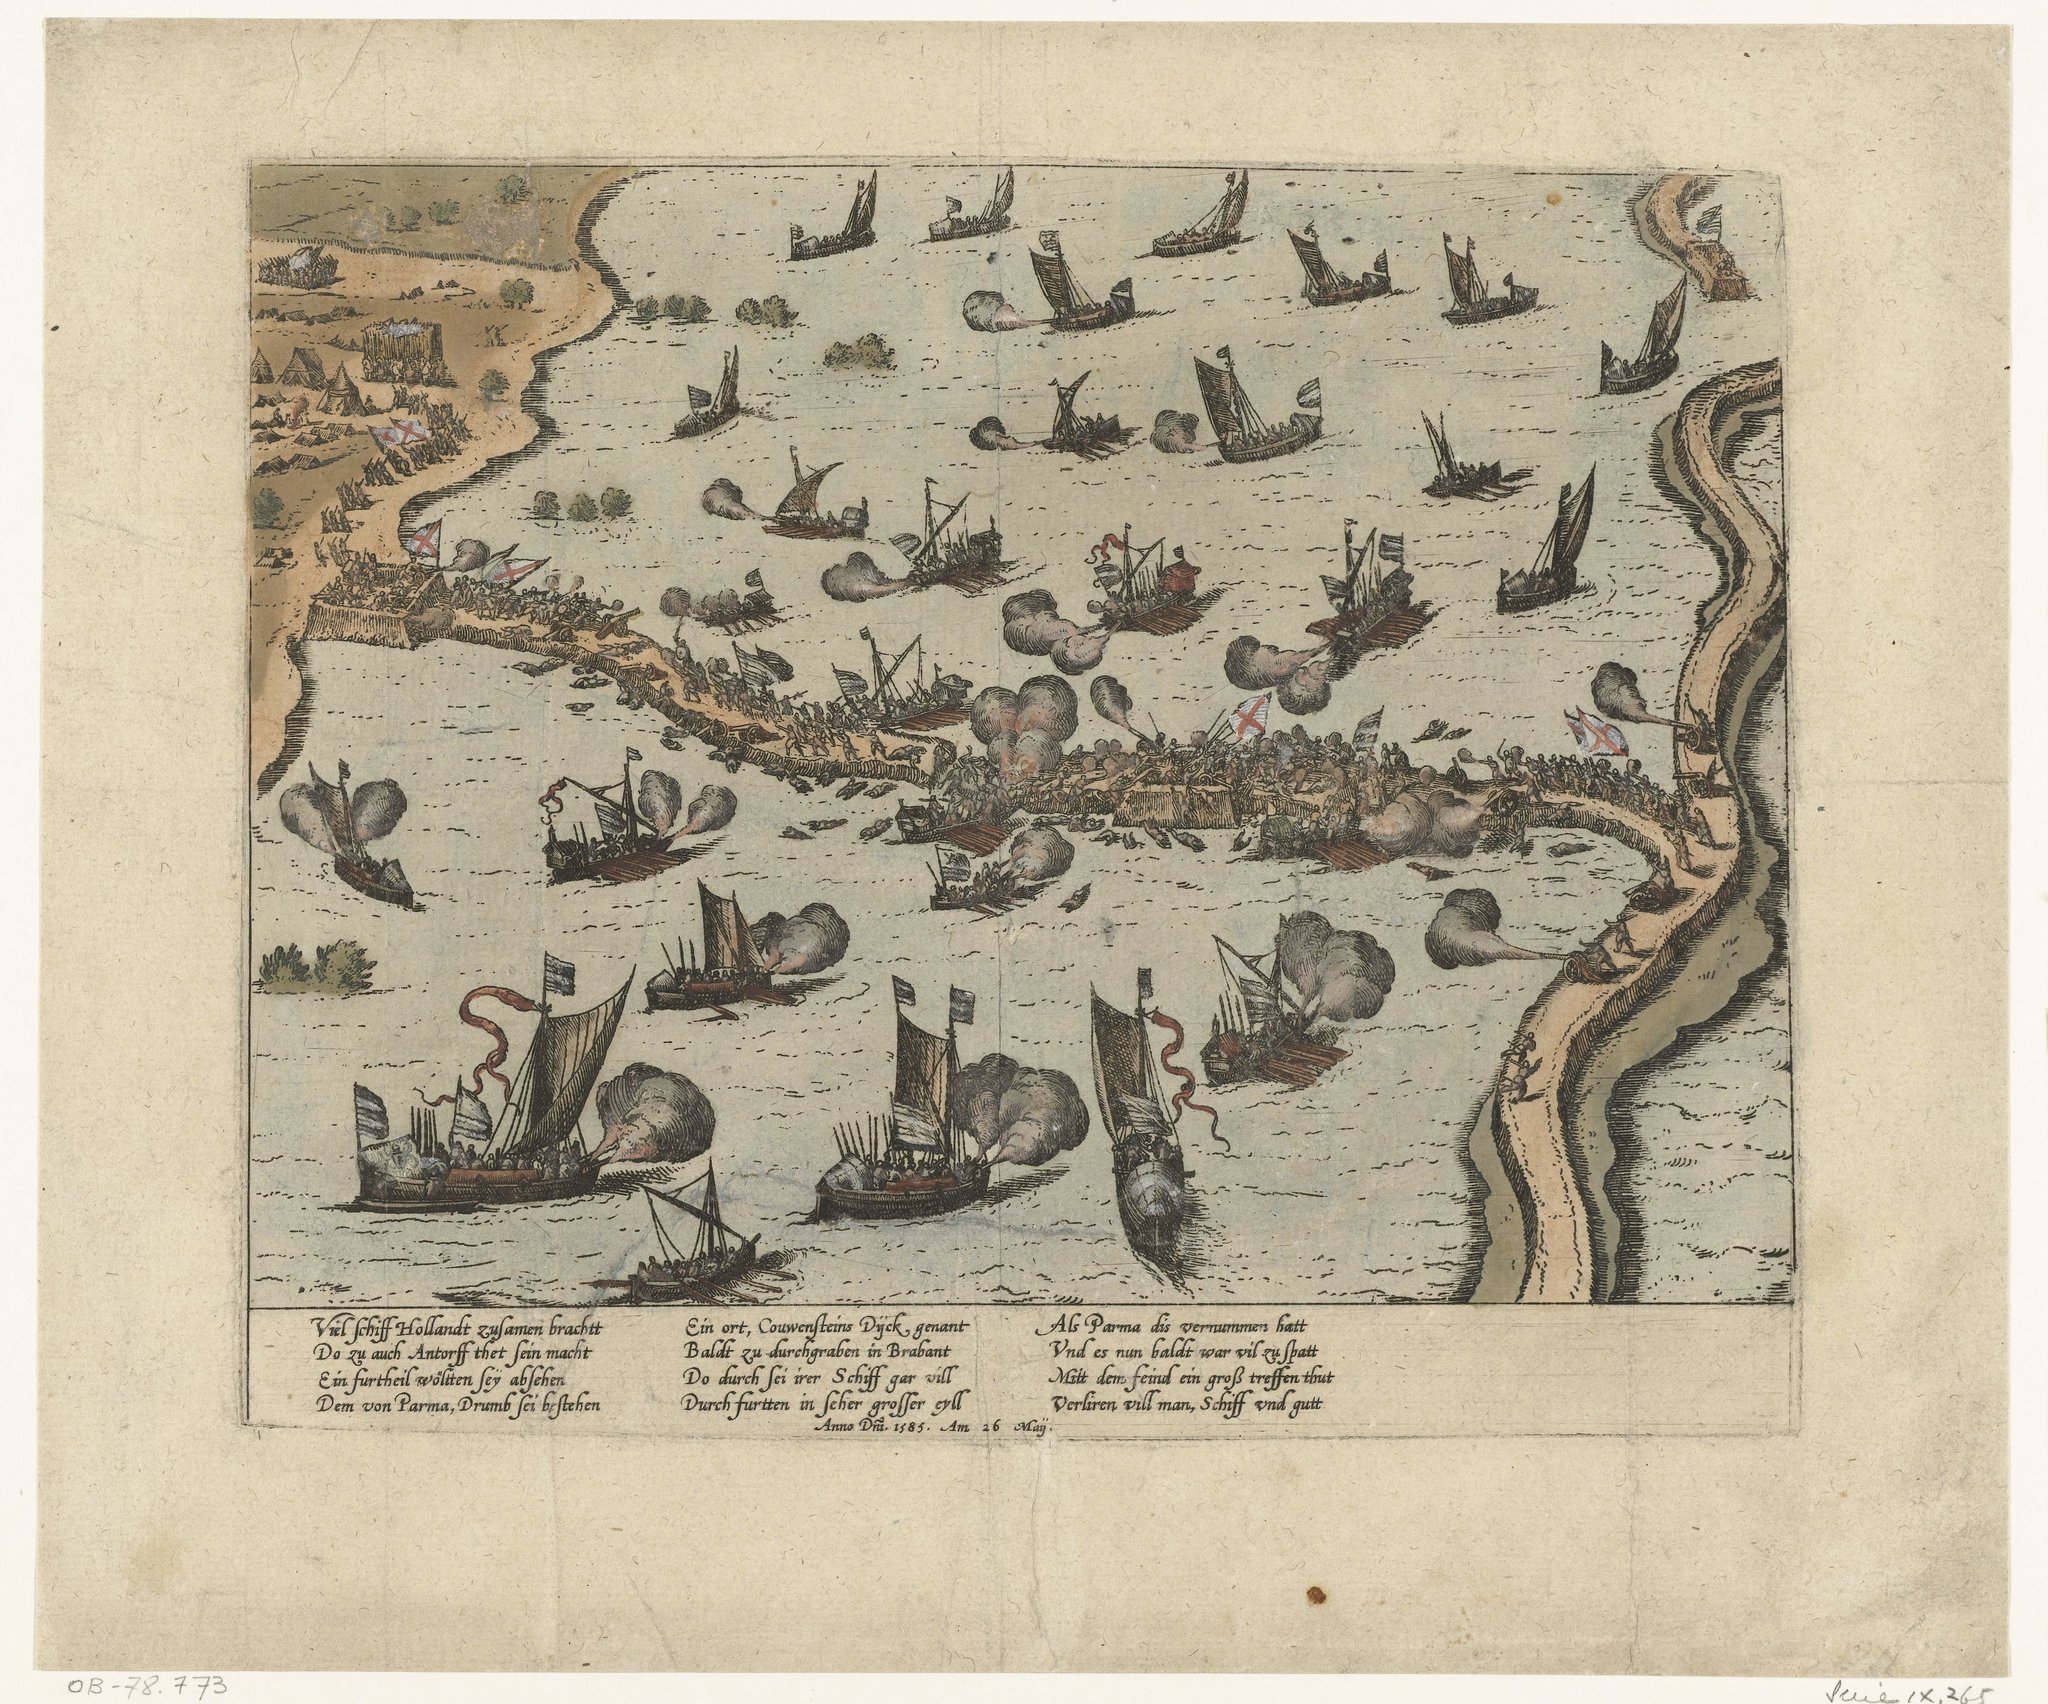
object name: print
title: Serie 9: Nederlandse en Duitse Gebeurtenissen, 1583-1587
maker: frans hogenberg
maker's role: print maker, publisher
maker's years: 1538-1590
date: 1585-1587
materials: paper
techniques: etching, hand coloring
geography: cologne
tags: battle, fighting in general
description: Slag op de Kauwensteinse dijk, 26 mei 1585. Aanval van het Staatse leger en Zeeuwse schepen op de dijk. Met onderschrift van 12 regels in het Duits. Ongenummerd.